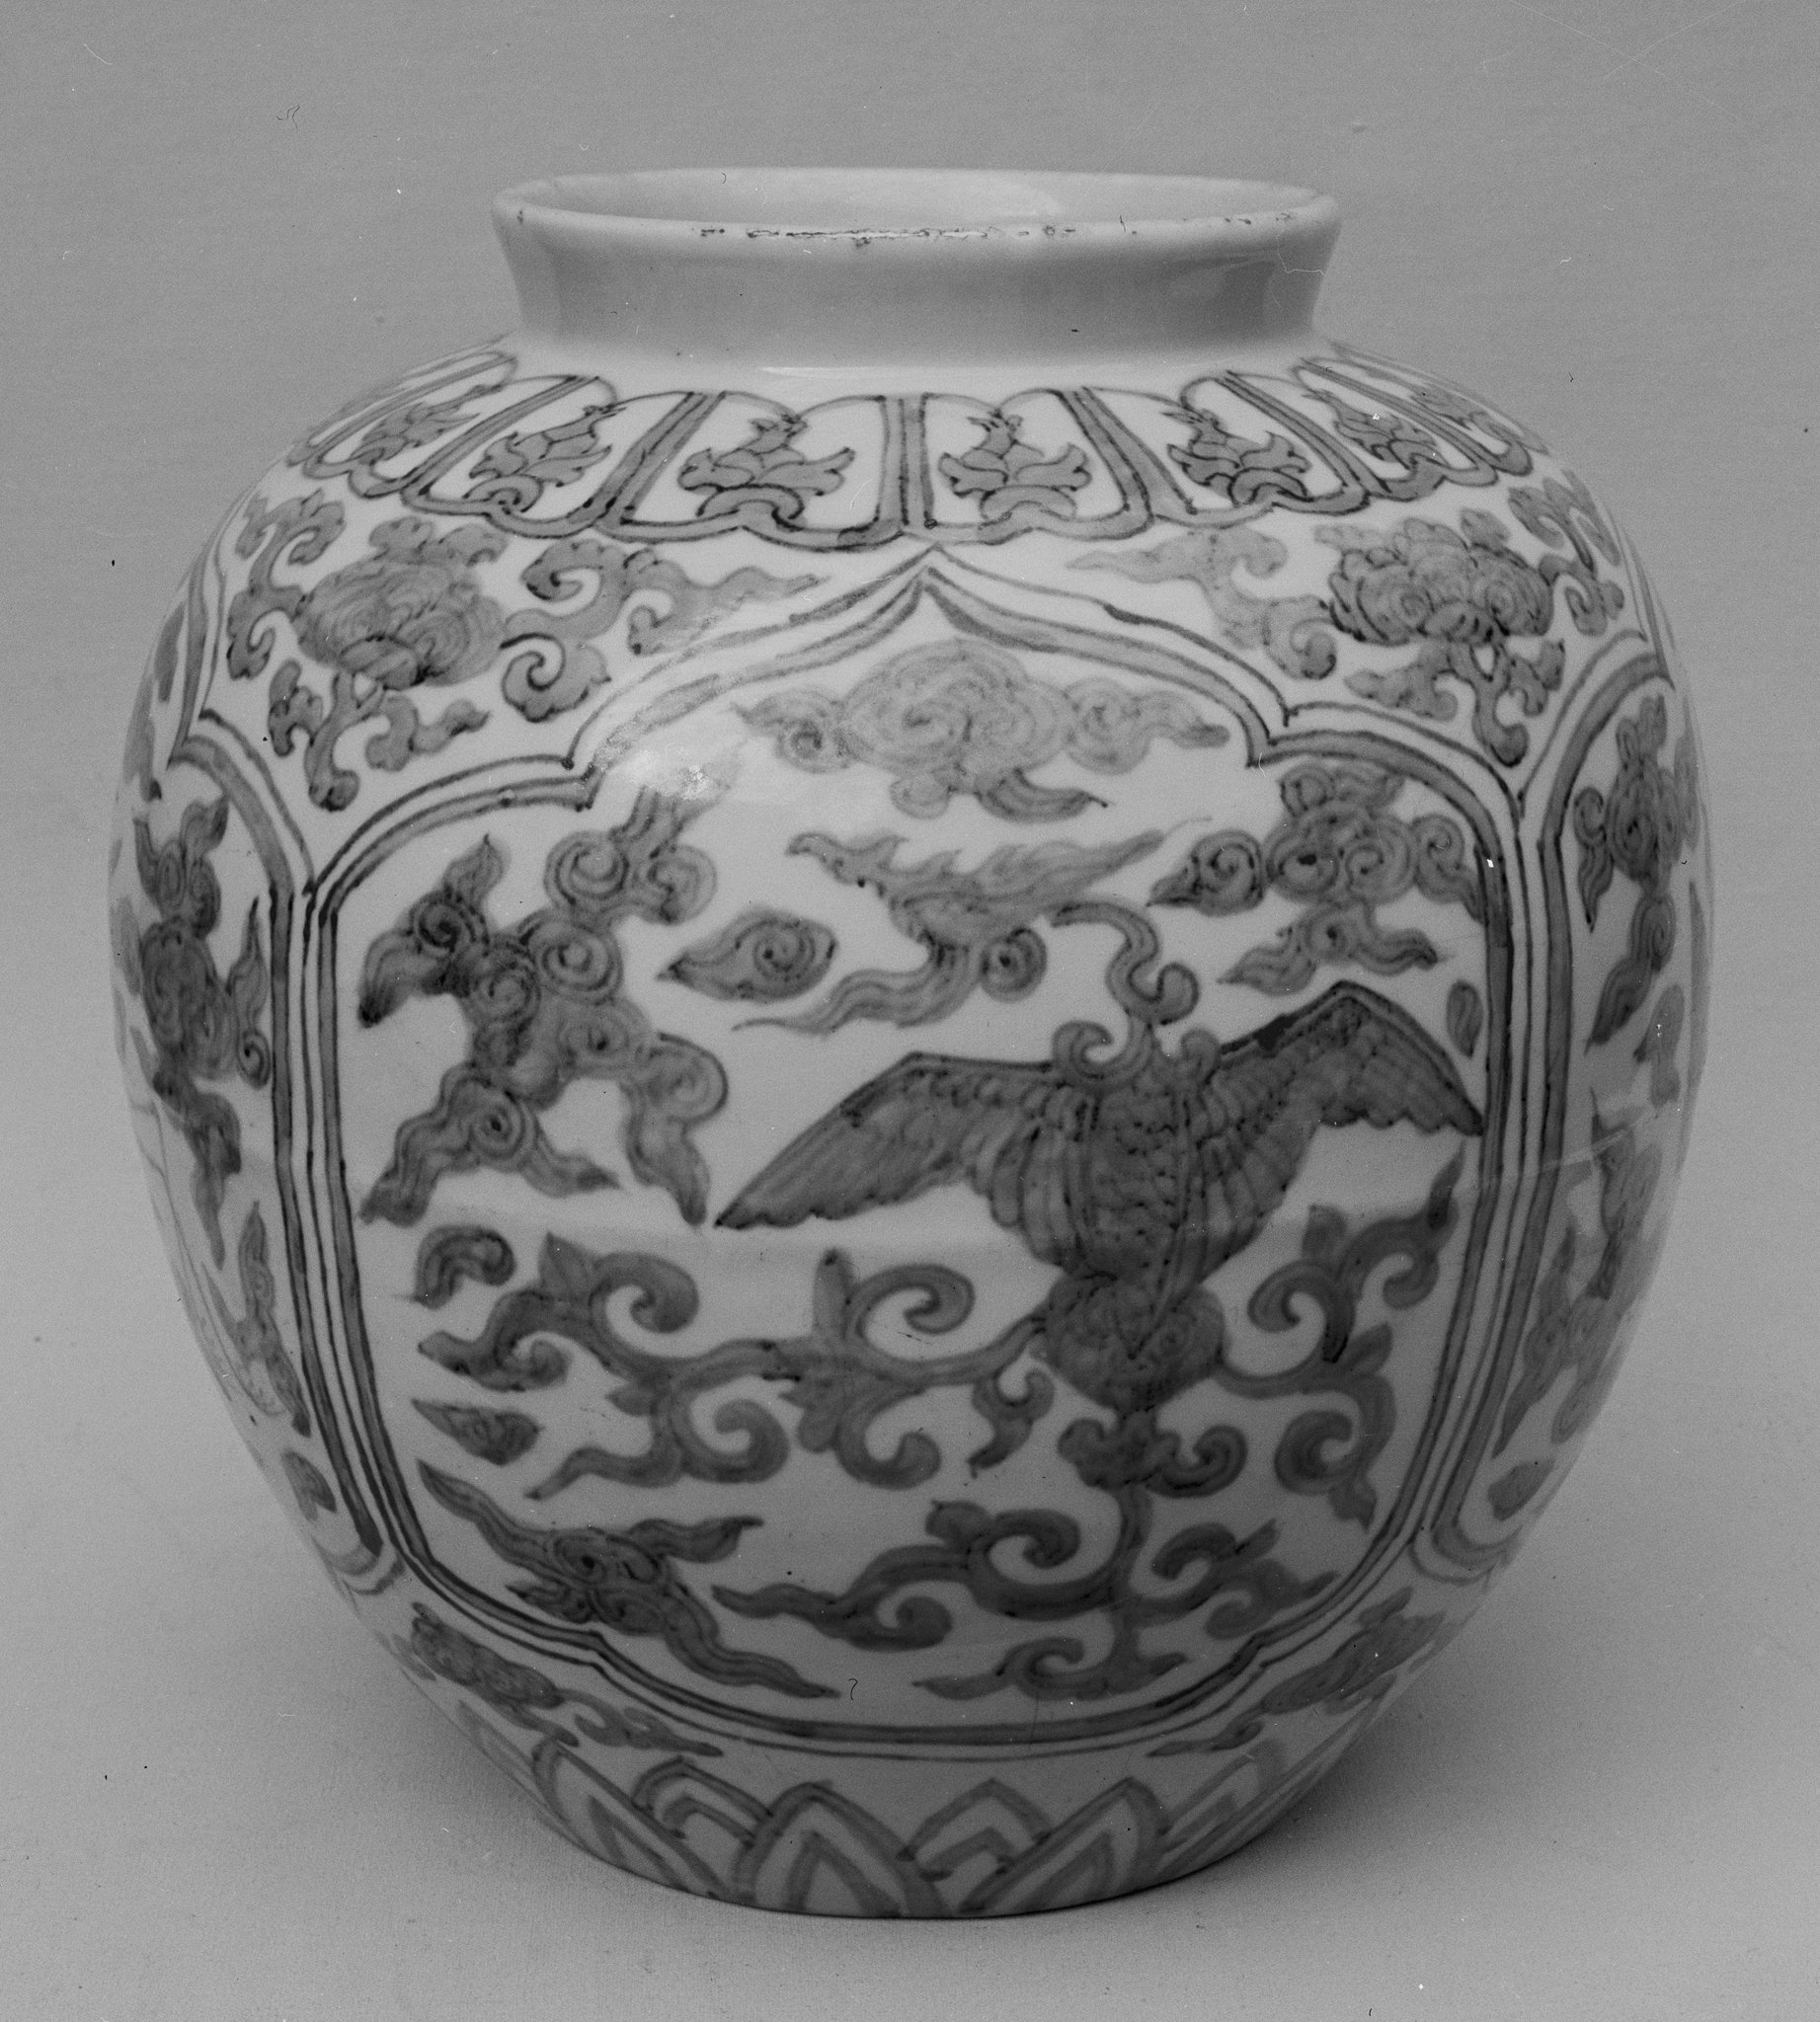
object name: jar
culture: chinese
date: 1522-1566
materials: porcelain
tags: birds